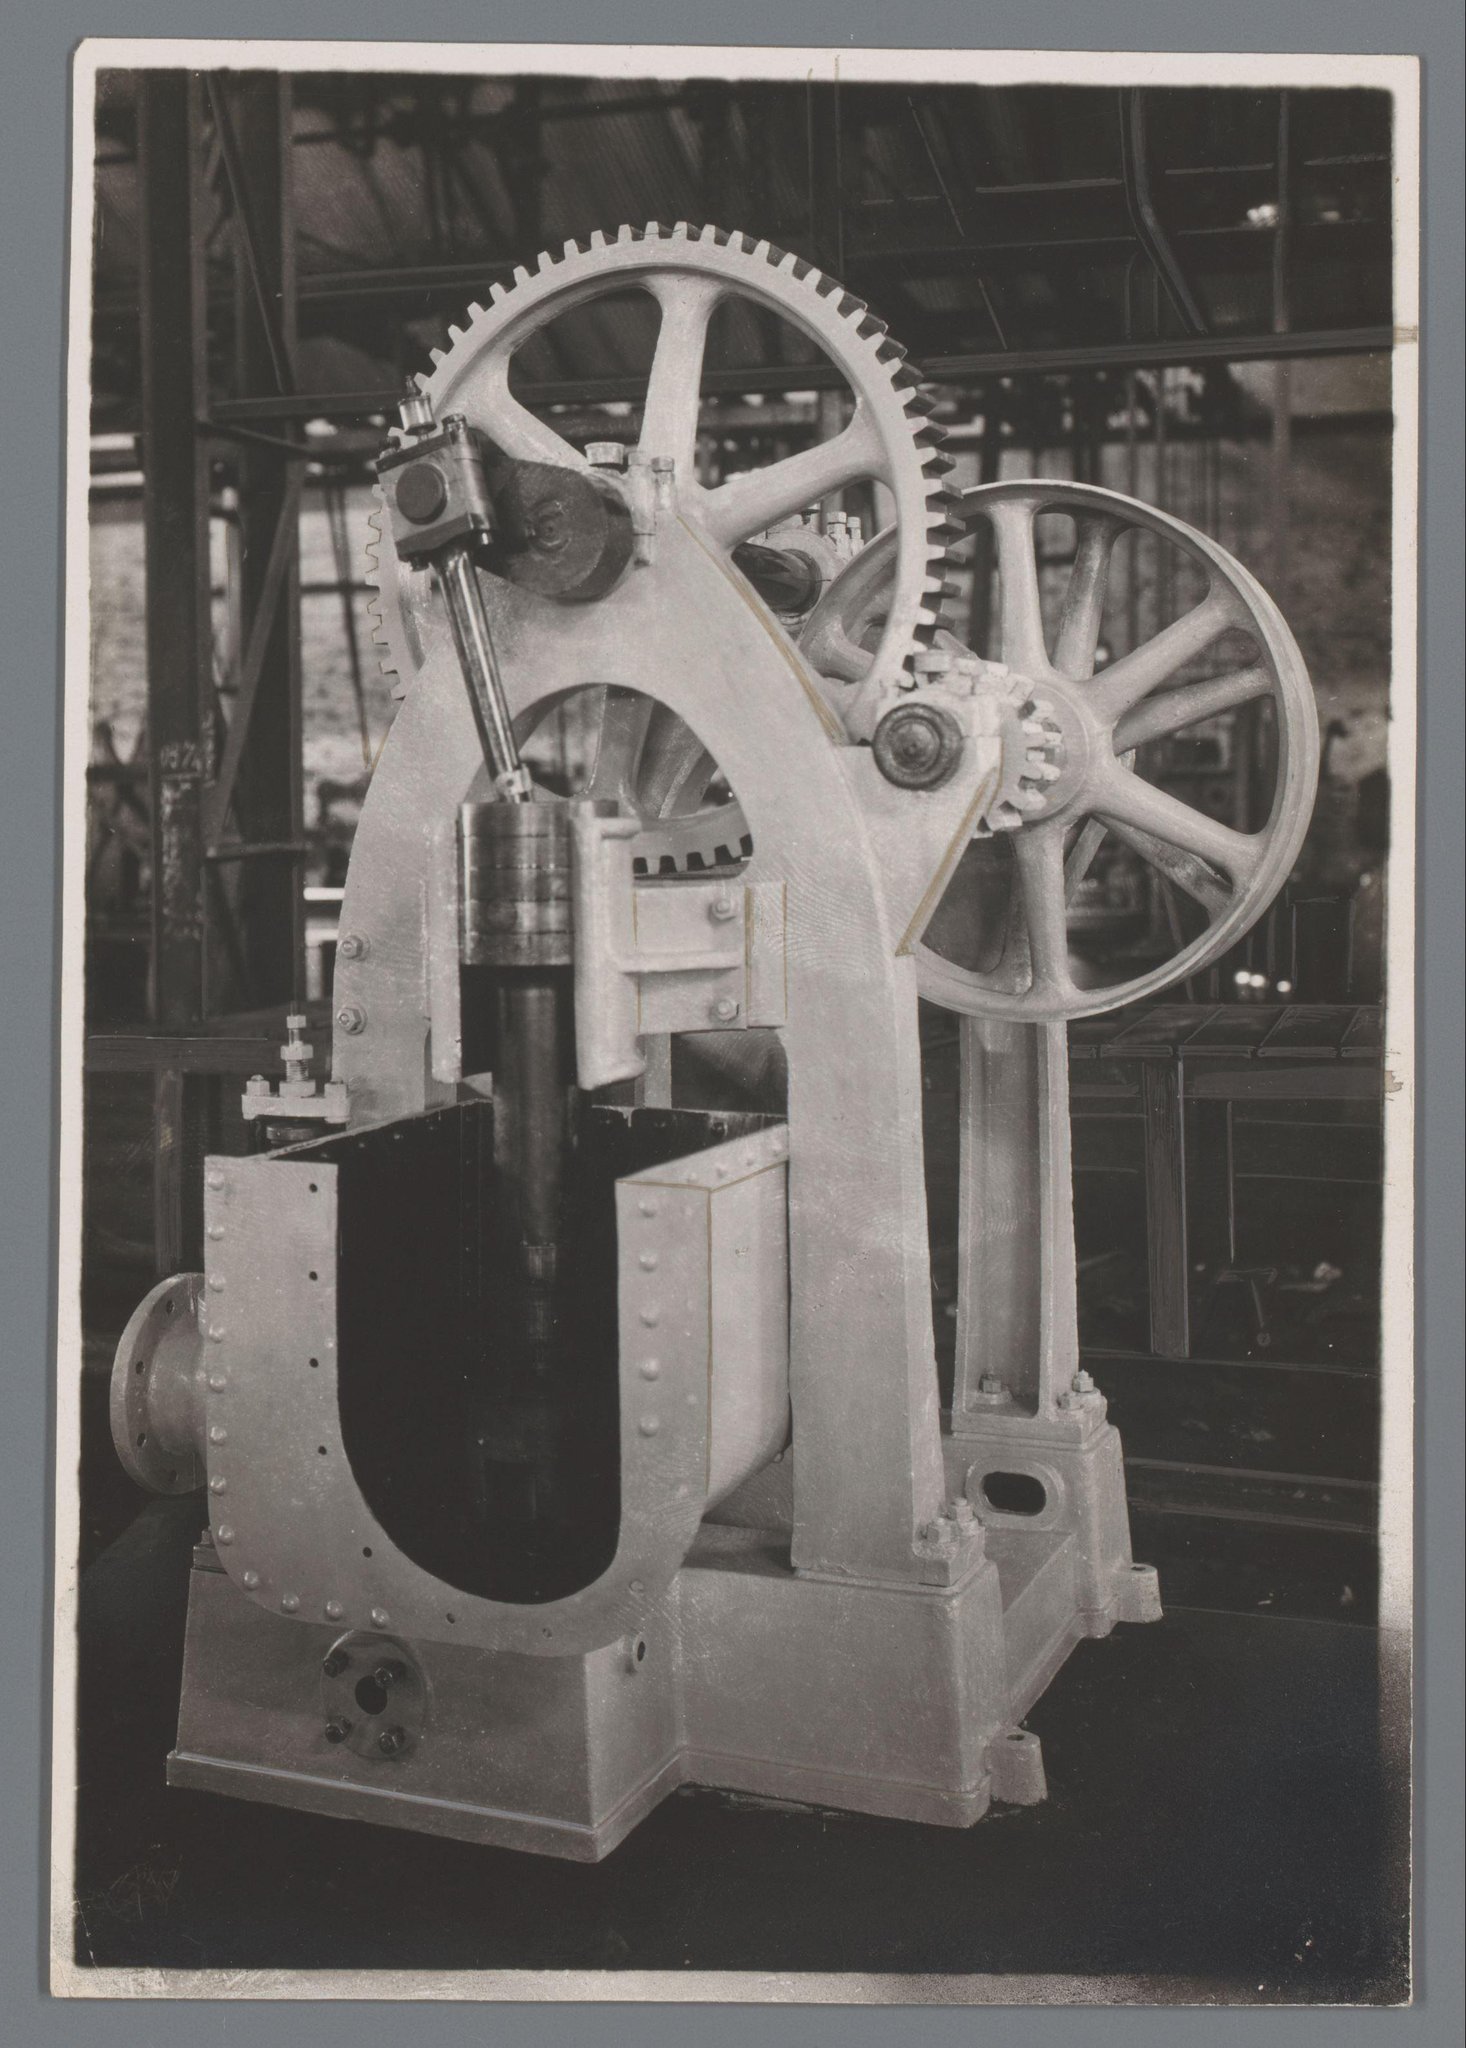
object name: photograph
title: Pomp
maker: Anonymous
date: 1923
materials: photographic support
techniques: gelatin silver print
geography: surabaya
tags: colonial system, factory-interior, machine shop, machines; parts of machines; tools and appliances, java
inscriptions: date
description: Een pomp, vervaardigd in 1923 en waarschijnlijk bestemd voor de suikerindustrie. Onderdeel van de multomap met foto's van machines van de N.V. Machinefabriek Braat te Soerabaja, Soekaboemi en Jogyakarta, uit de periode 1908-1942.